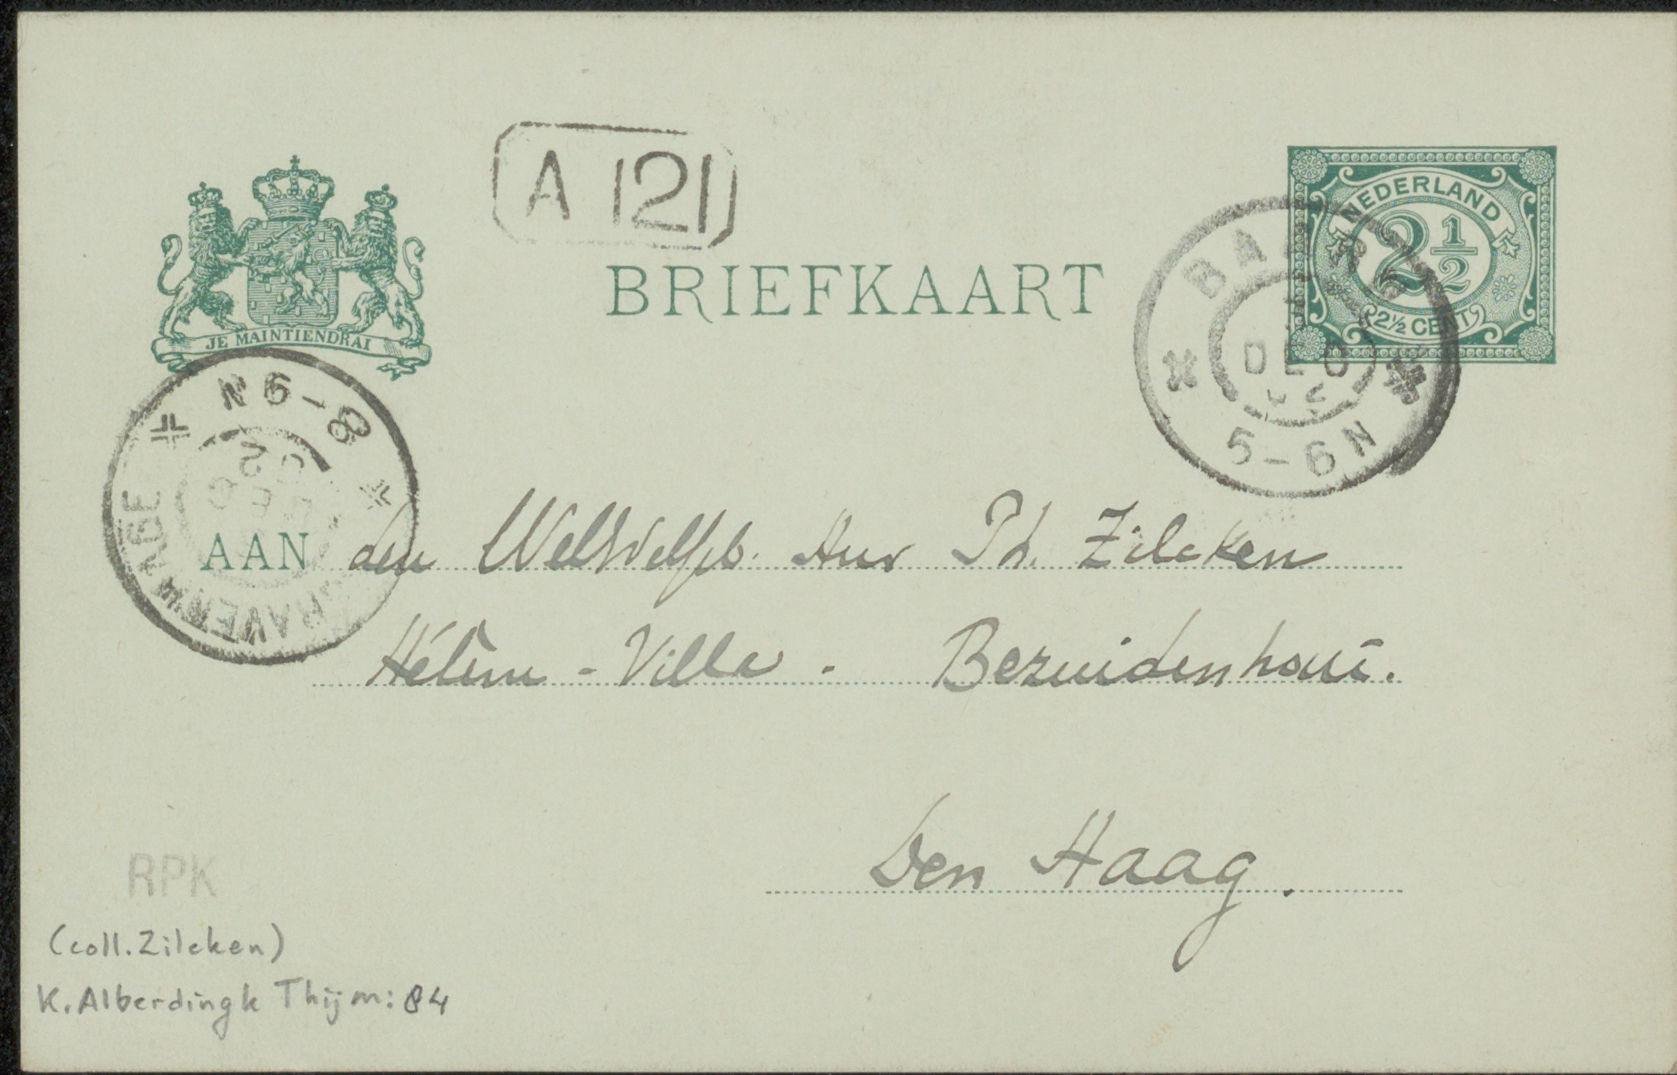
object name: postcard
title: Briefkaart aan Philip Zilcken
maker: karel johan lodewijk alberdingk thijm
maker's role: criticus, prozaschrijver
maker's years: 1864-1952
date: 1902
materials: cardboard, ink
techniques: pen, writing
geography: baarn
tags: the hague, painter, draughtsman, philip zilcken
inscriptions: collector's mark: ‘RPK’